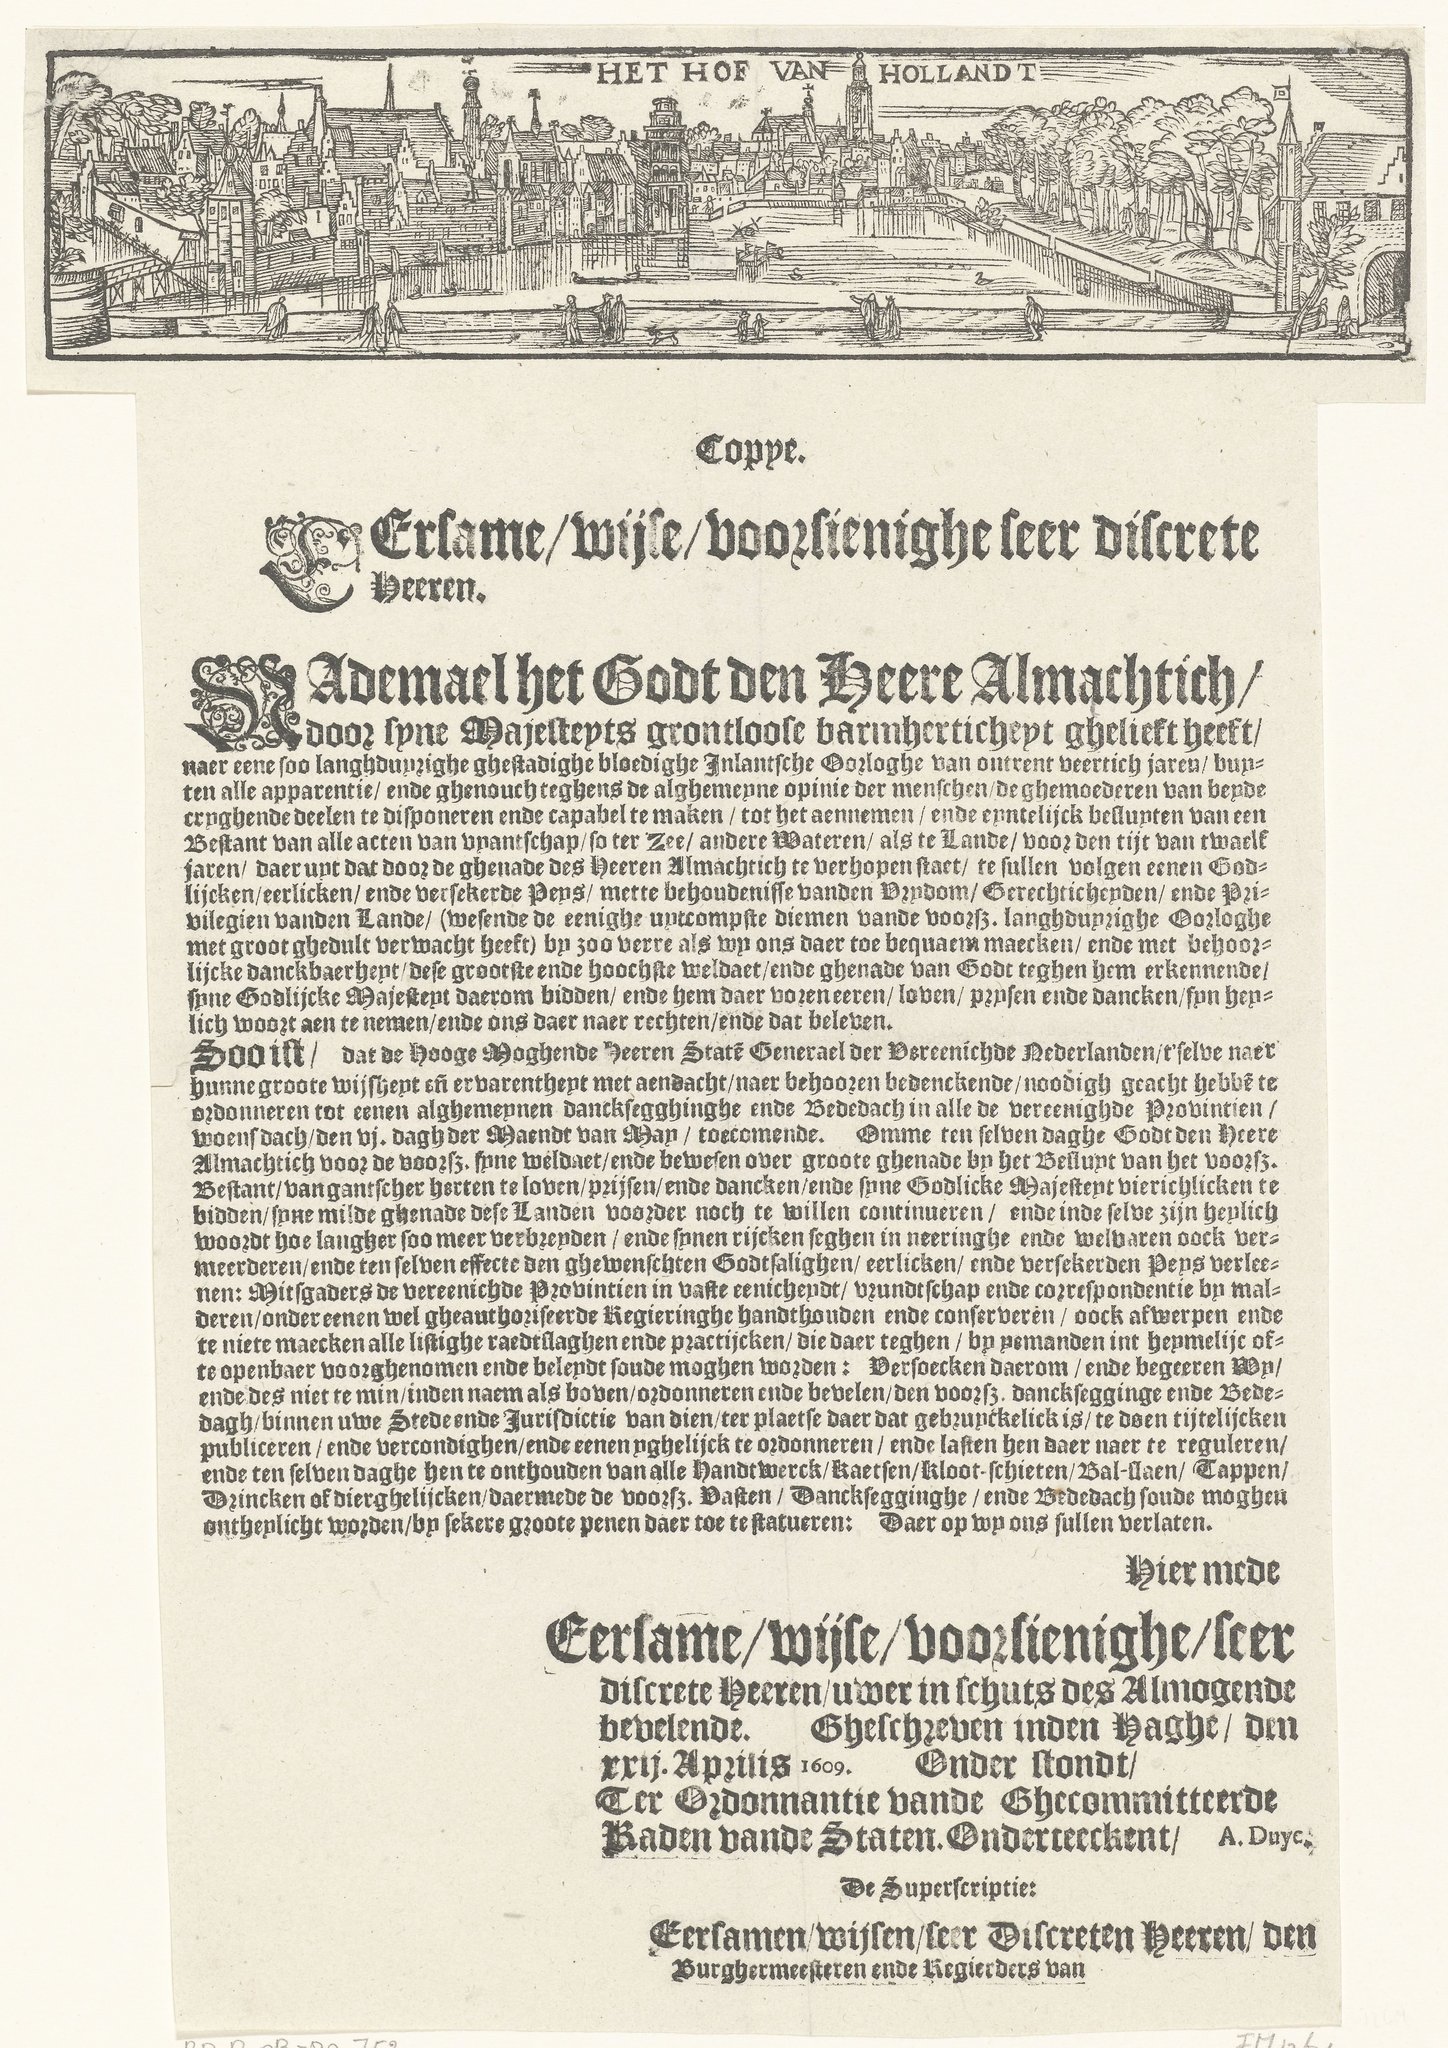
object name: print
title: Aankondiging van een dankdag over het Bestand, 1609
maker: Anonymous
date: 1609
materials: paper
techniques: letterpress printing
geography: northern netherlands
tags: binnenhof, hofvijver, twaalfjarig bestand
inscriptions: date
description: Aankondiging door de Staten-Generaal van een algemene dankdag en gebedsdag op 6 mei 1609, om op die dag God te danken voor het bereikte Bestand, bekendgemaakt op 22 april 1609. Gezicht over de Hofvijver op het Binnenhof, de regeringsgebouwen te Den Haag, aangeduid als Het Hof van Hollandt. Hieronder de bekendmaking in het Nederlands.